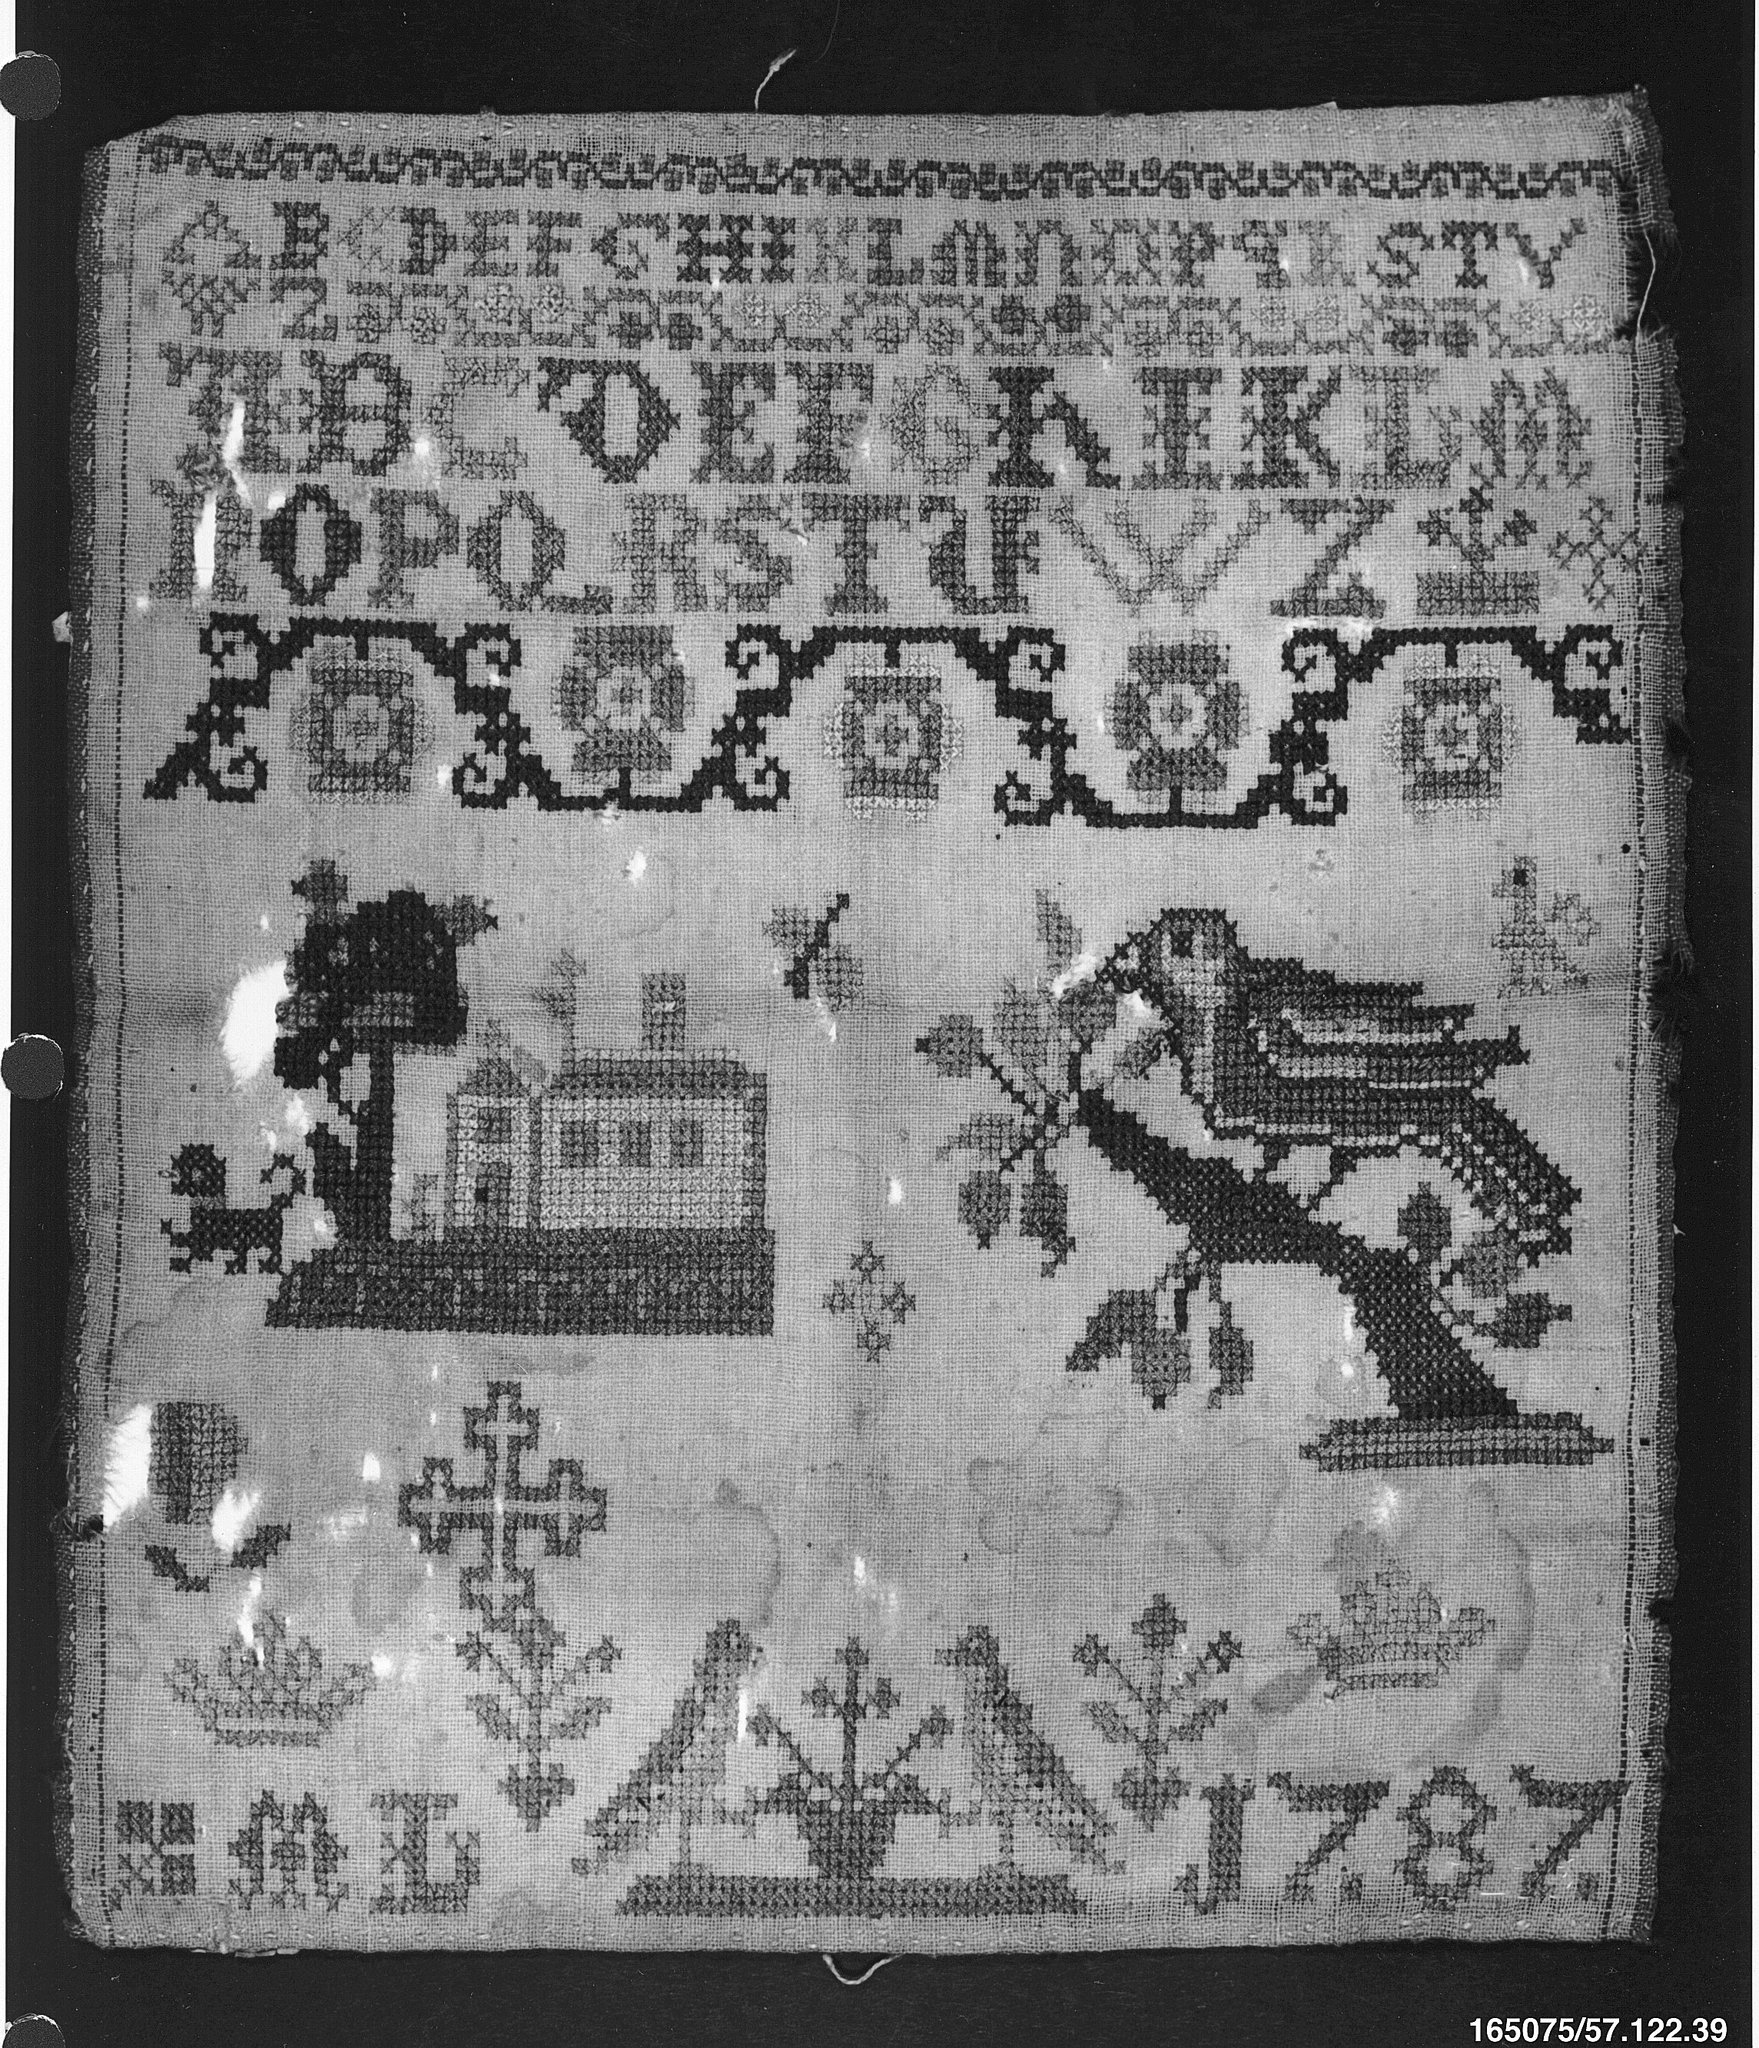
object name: sampler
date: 1787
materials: wool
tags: birds,houses